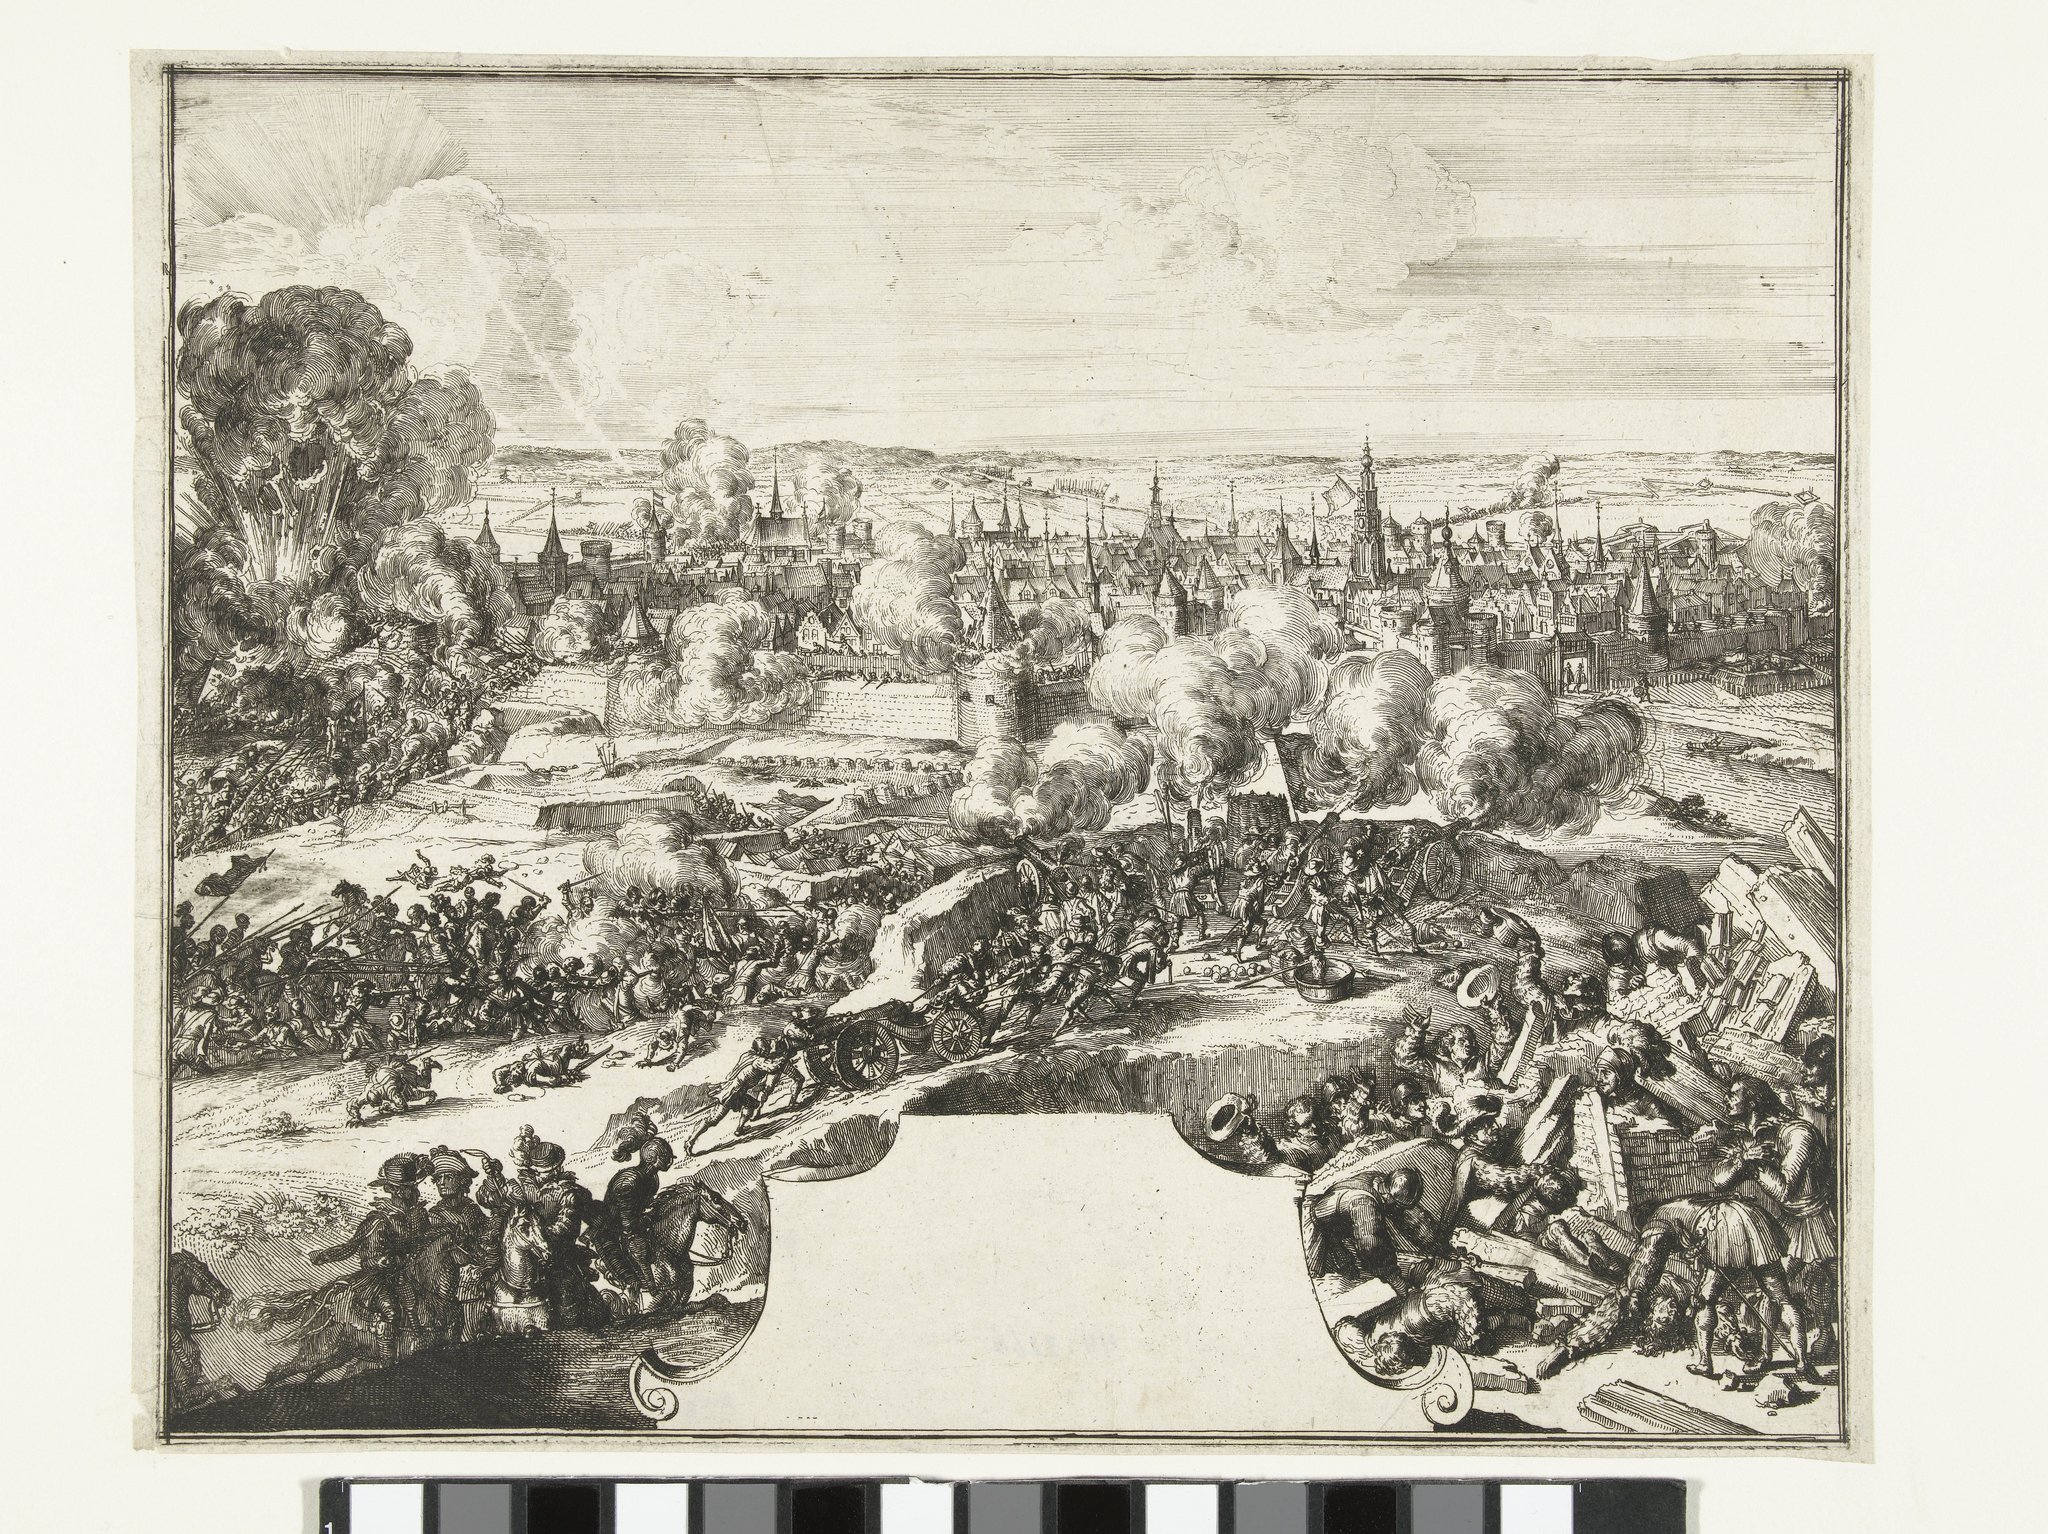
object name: history print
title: Inname van Doornik, 1581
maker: romeyn de hooghe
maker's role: draughtsman, goldsmith, painter, print maker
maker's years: 1645-1708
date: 1670-1699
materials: paper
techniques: etching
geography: netherlands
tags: rome, alessandro farnese (landvoogd van de nederlanden en hertog van parma en piacenza), capture of city (after the siege)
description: Beleg en inname van Doornik door het leger van de hertog van Parma, 29 november 1581. Rechts voor staat de hertog van Parma wonderbaarlijk ongedeerd tussen de ruïnes van een gebouw. Middenonder een lege cartouche.